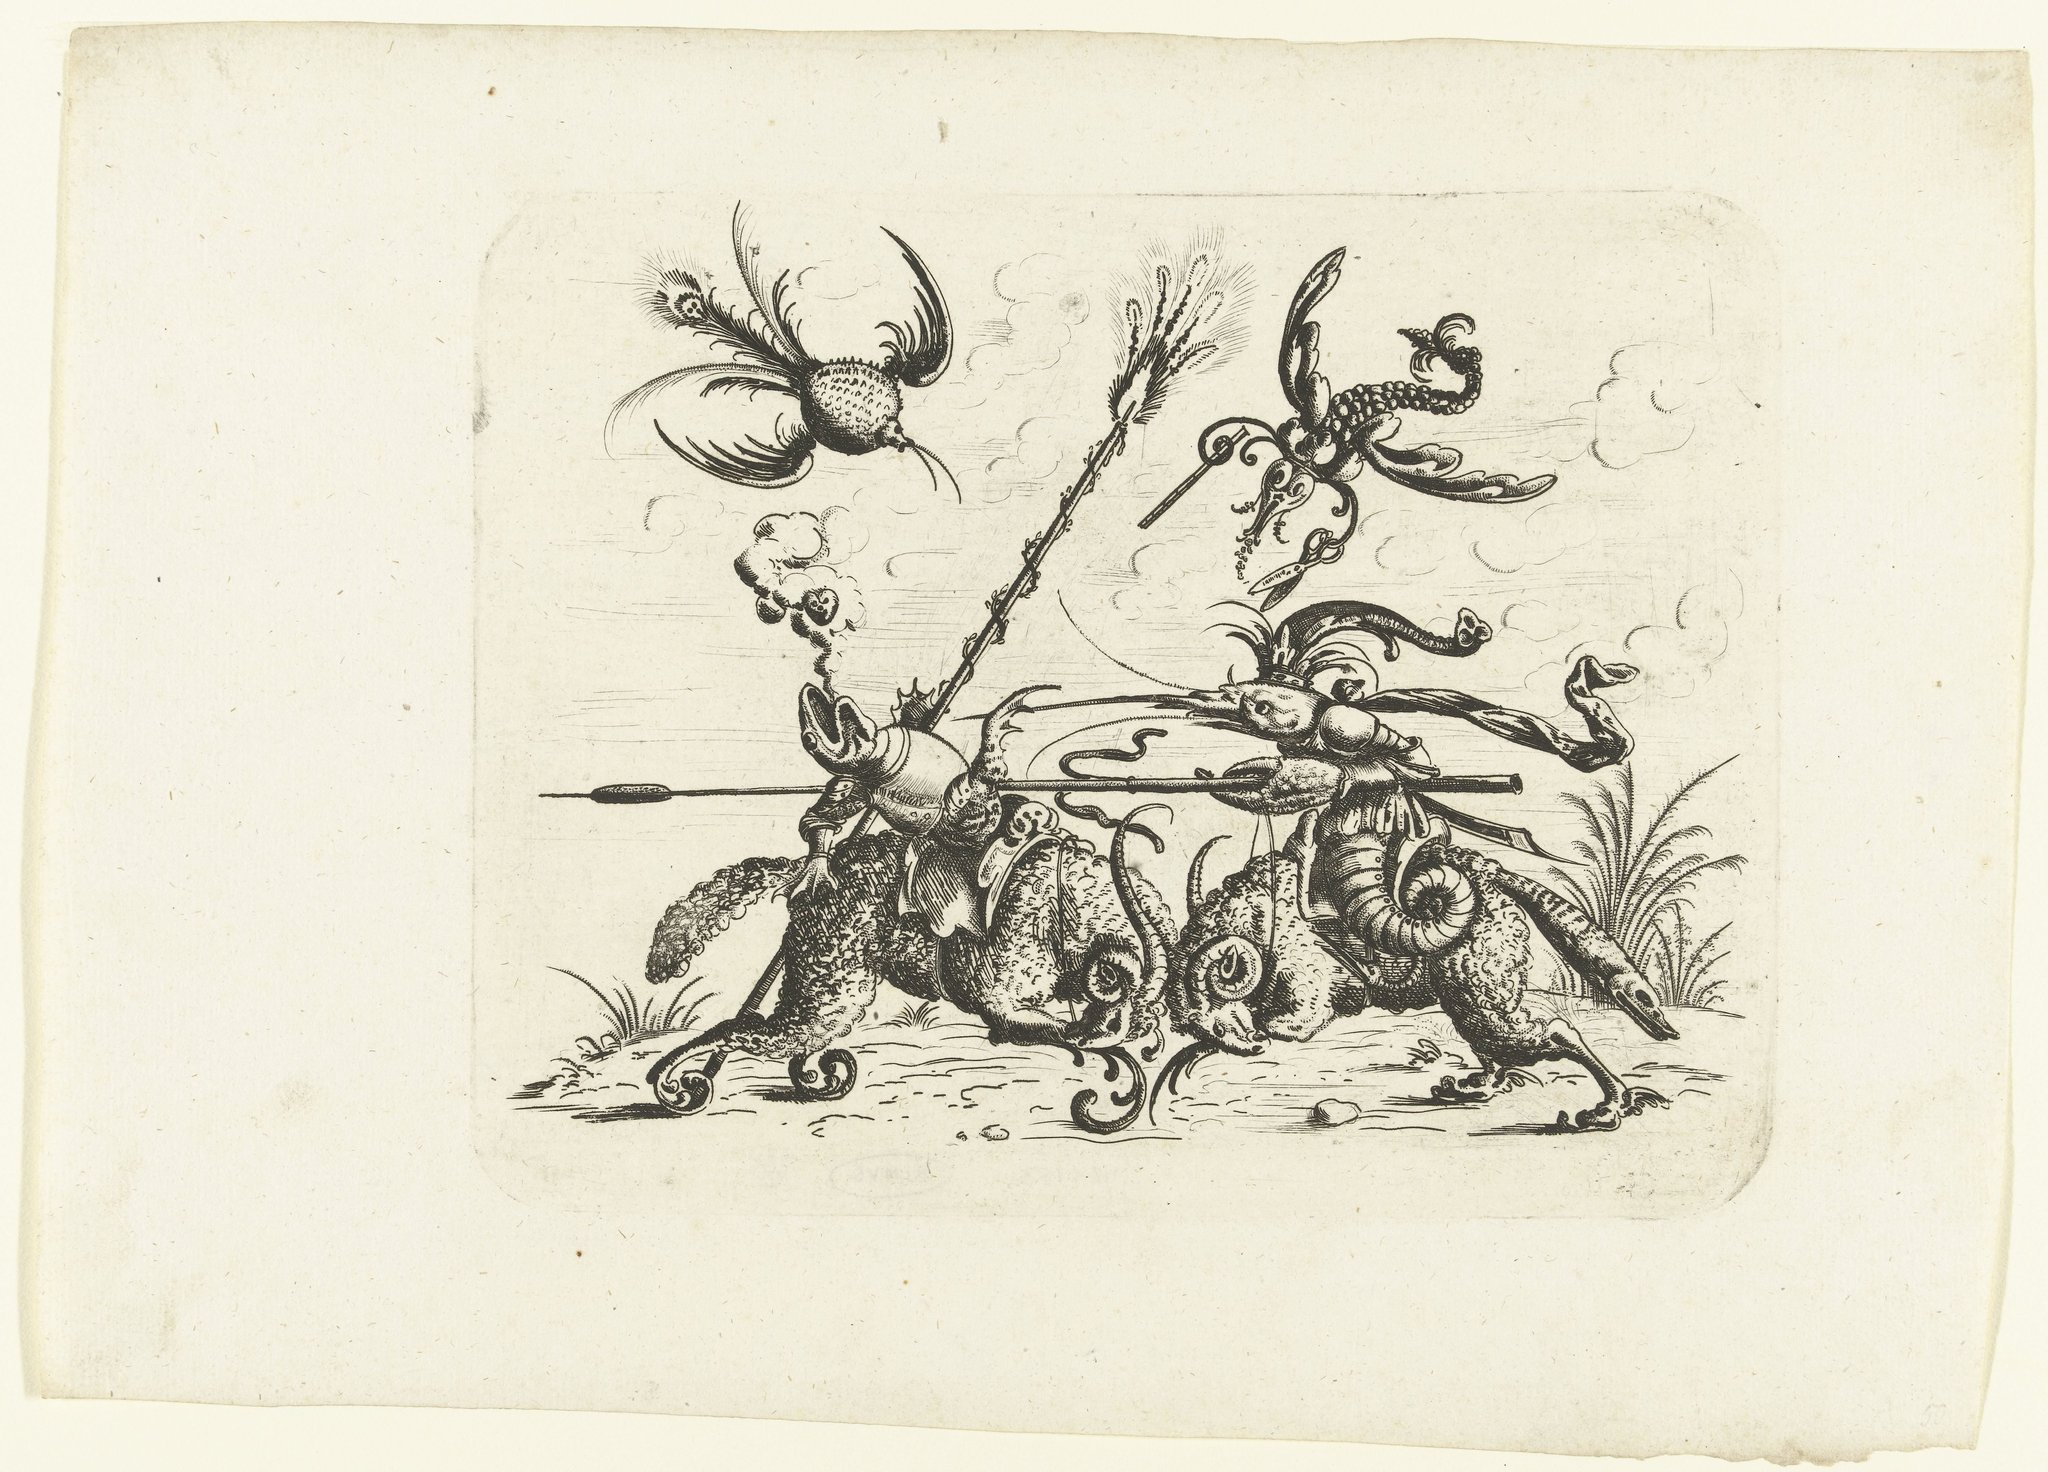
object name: print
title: Gevecht tussen een kikker en een kreeft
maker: christoph jamnitzer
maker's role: draughtsman, goldsmith, print maker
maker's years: 1563-1618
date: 1573-1610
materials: paper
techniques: etching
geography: germany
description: De kreeft, rijdend op een ram, doorboort de kikker, rijdend op een geitebok, met een lisdodde. Blad uit een serie vlakdecoraties met grotesken, cartouches, ovalen, mascarons, putti en fantastische wezens. De serie bestaat uit drie titelbladen, twee tekstbladen met de opdracht en het voorwoord en 60 bladen, verdeeld over drie boeken.